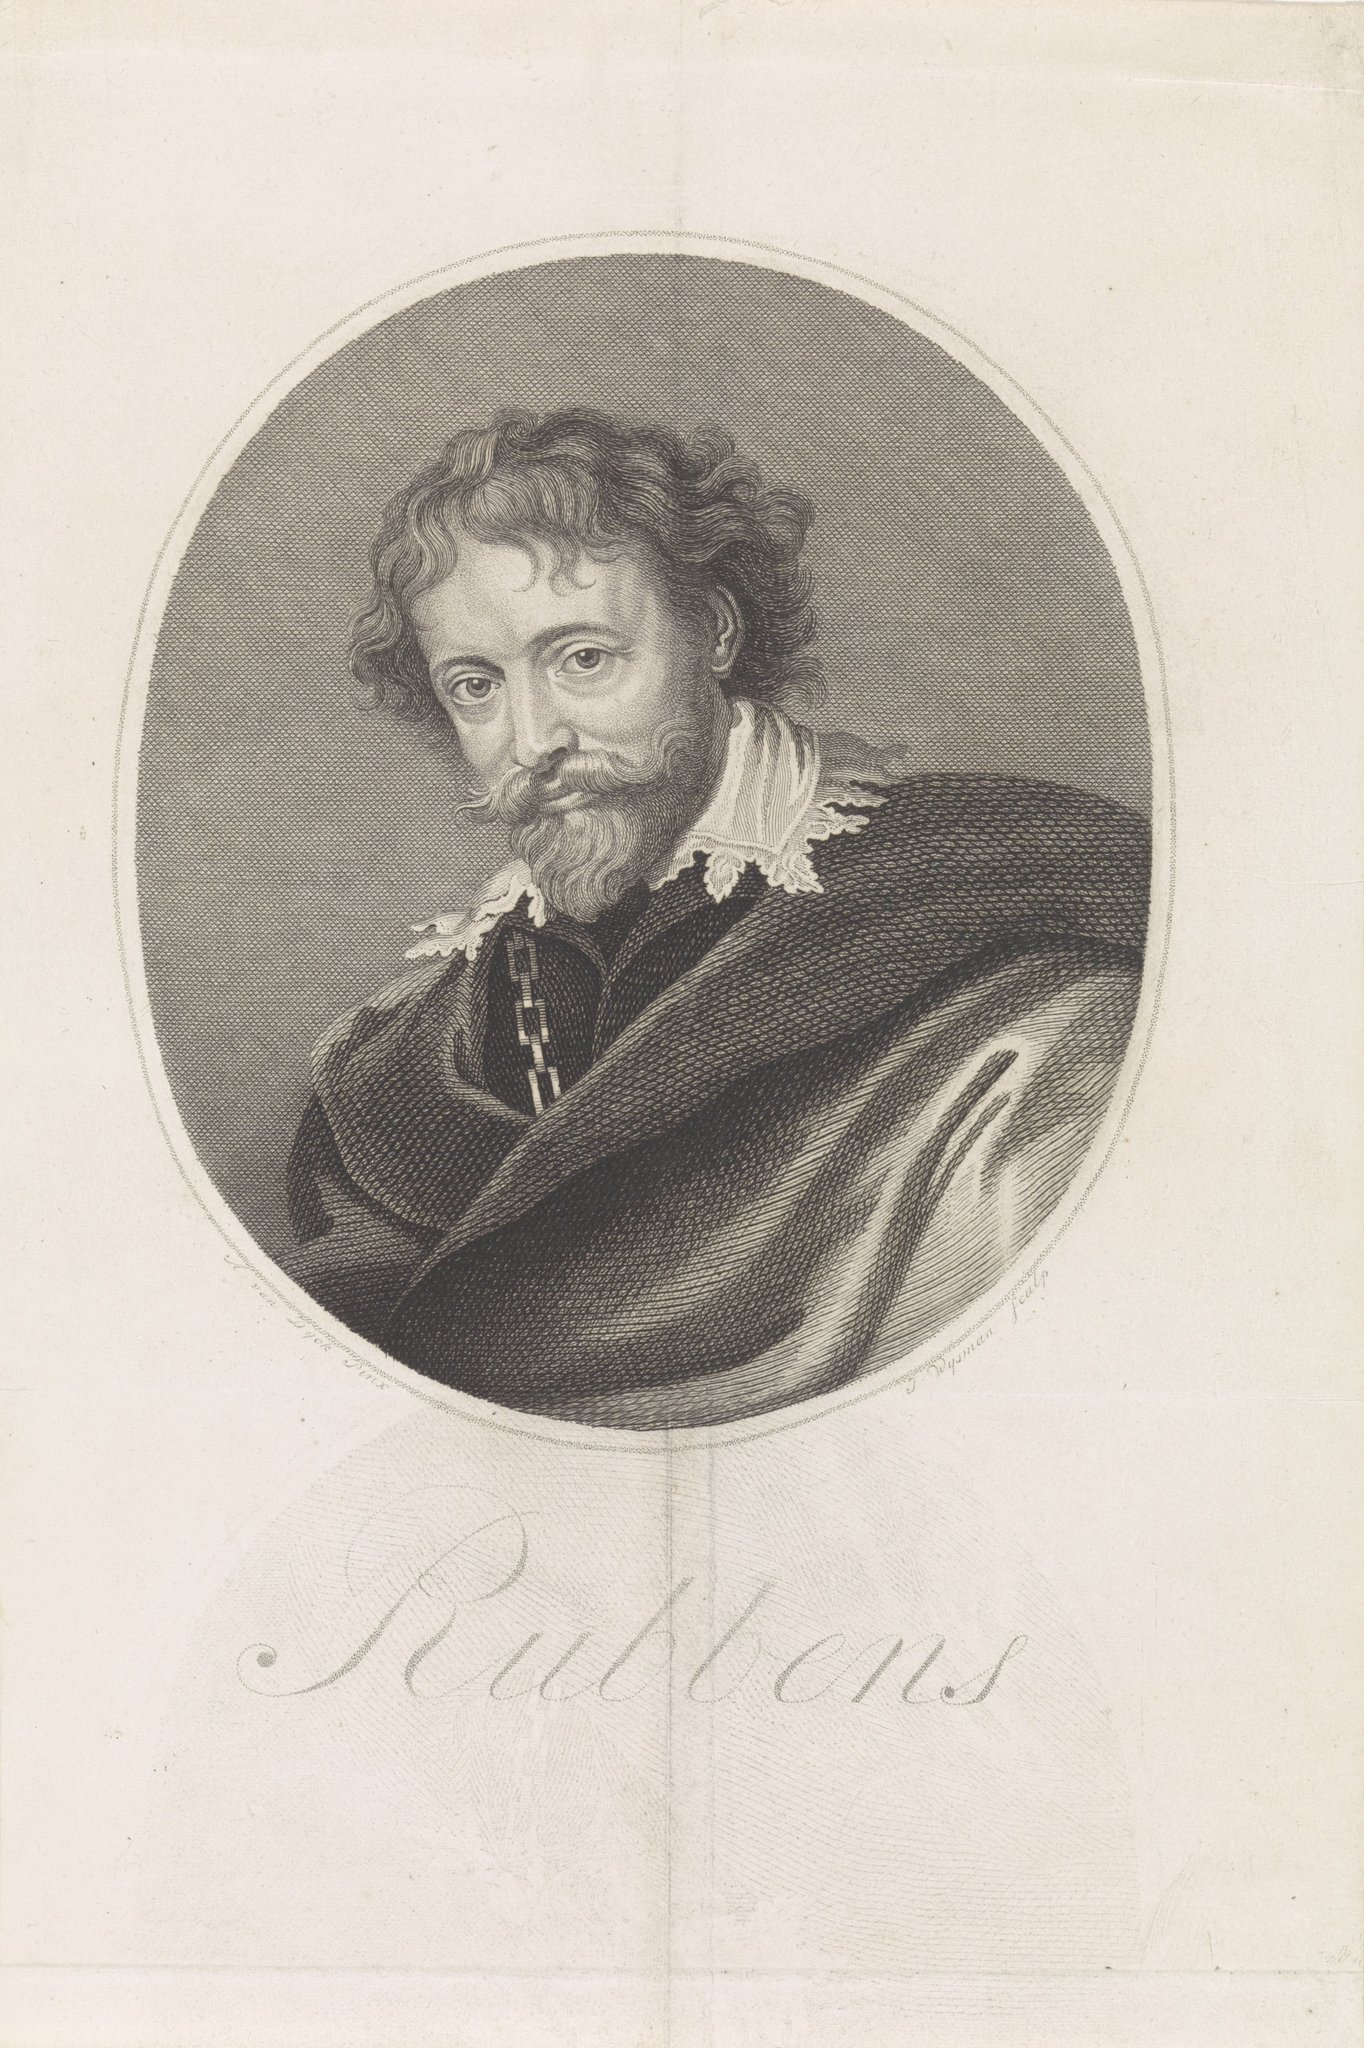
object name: print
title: Rubbens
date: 1778-1827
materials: paper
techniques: engraving, etching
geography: amsterdam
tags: antwerp, painter, print maker, draughtsman, peter paul rubens